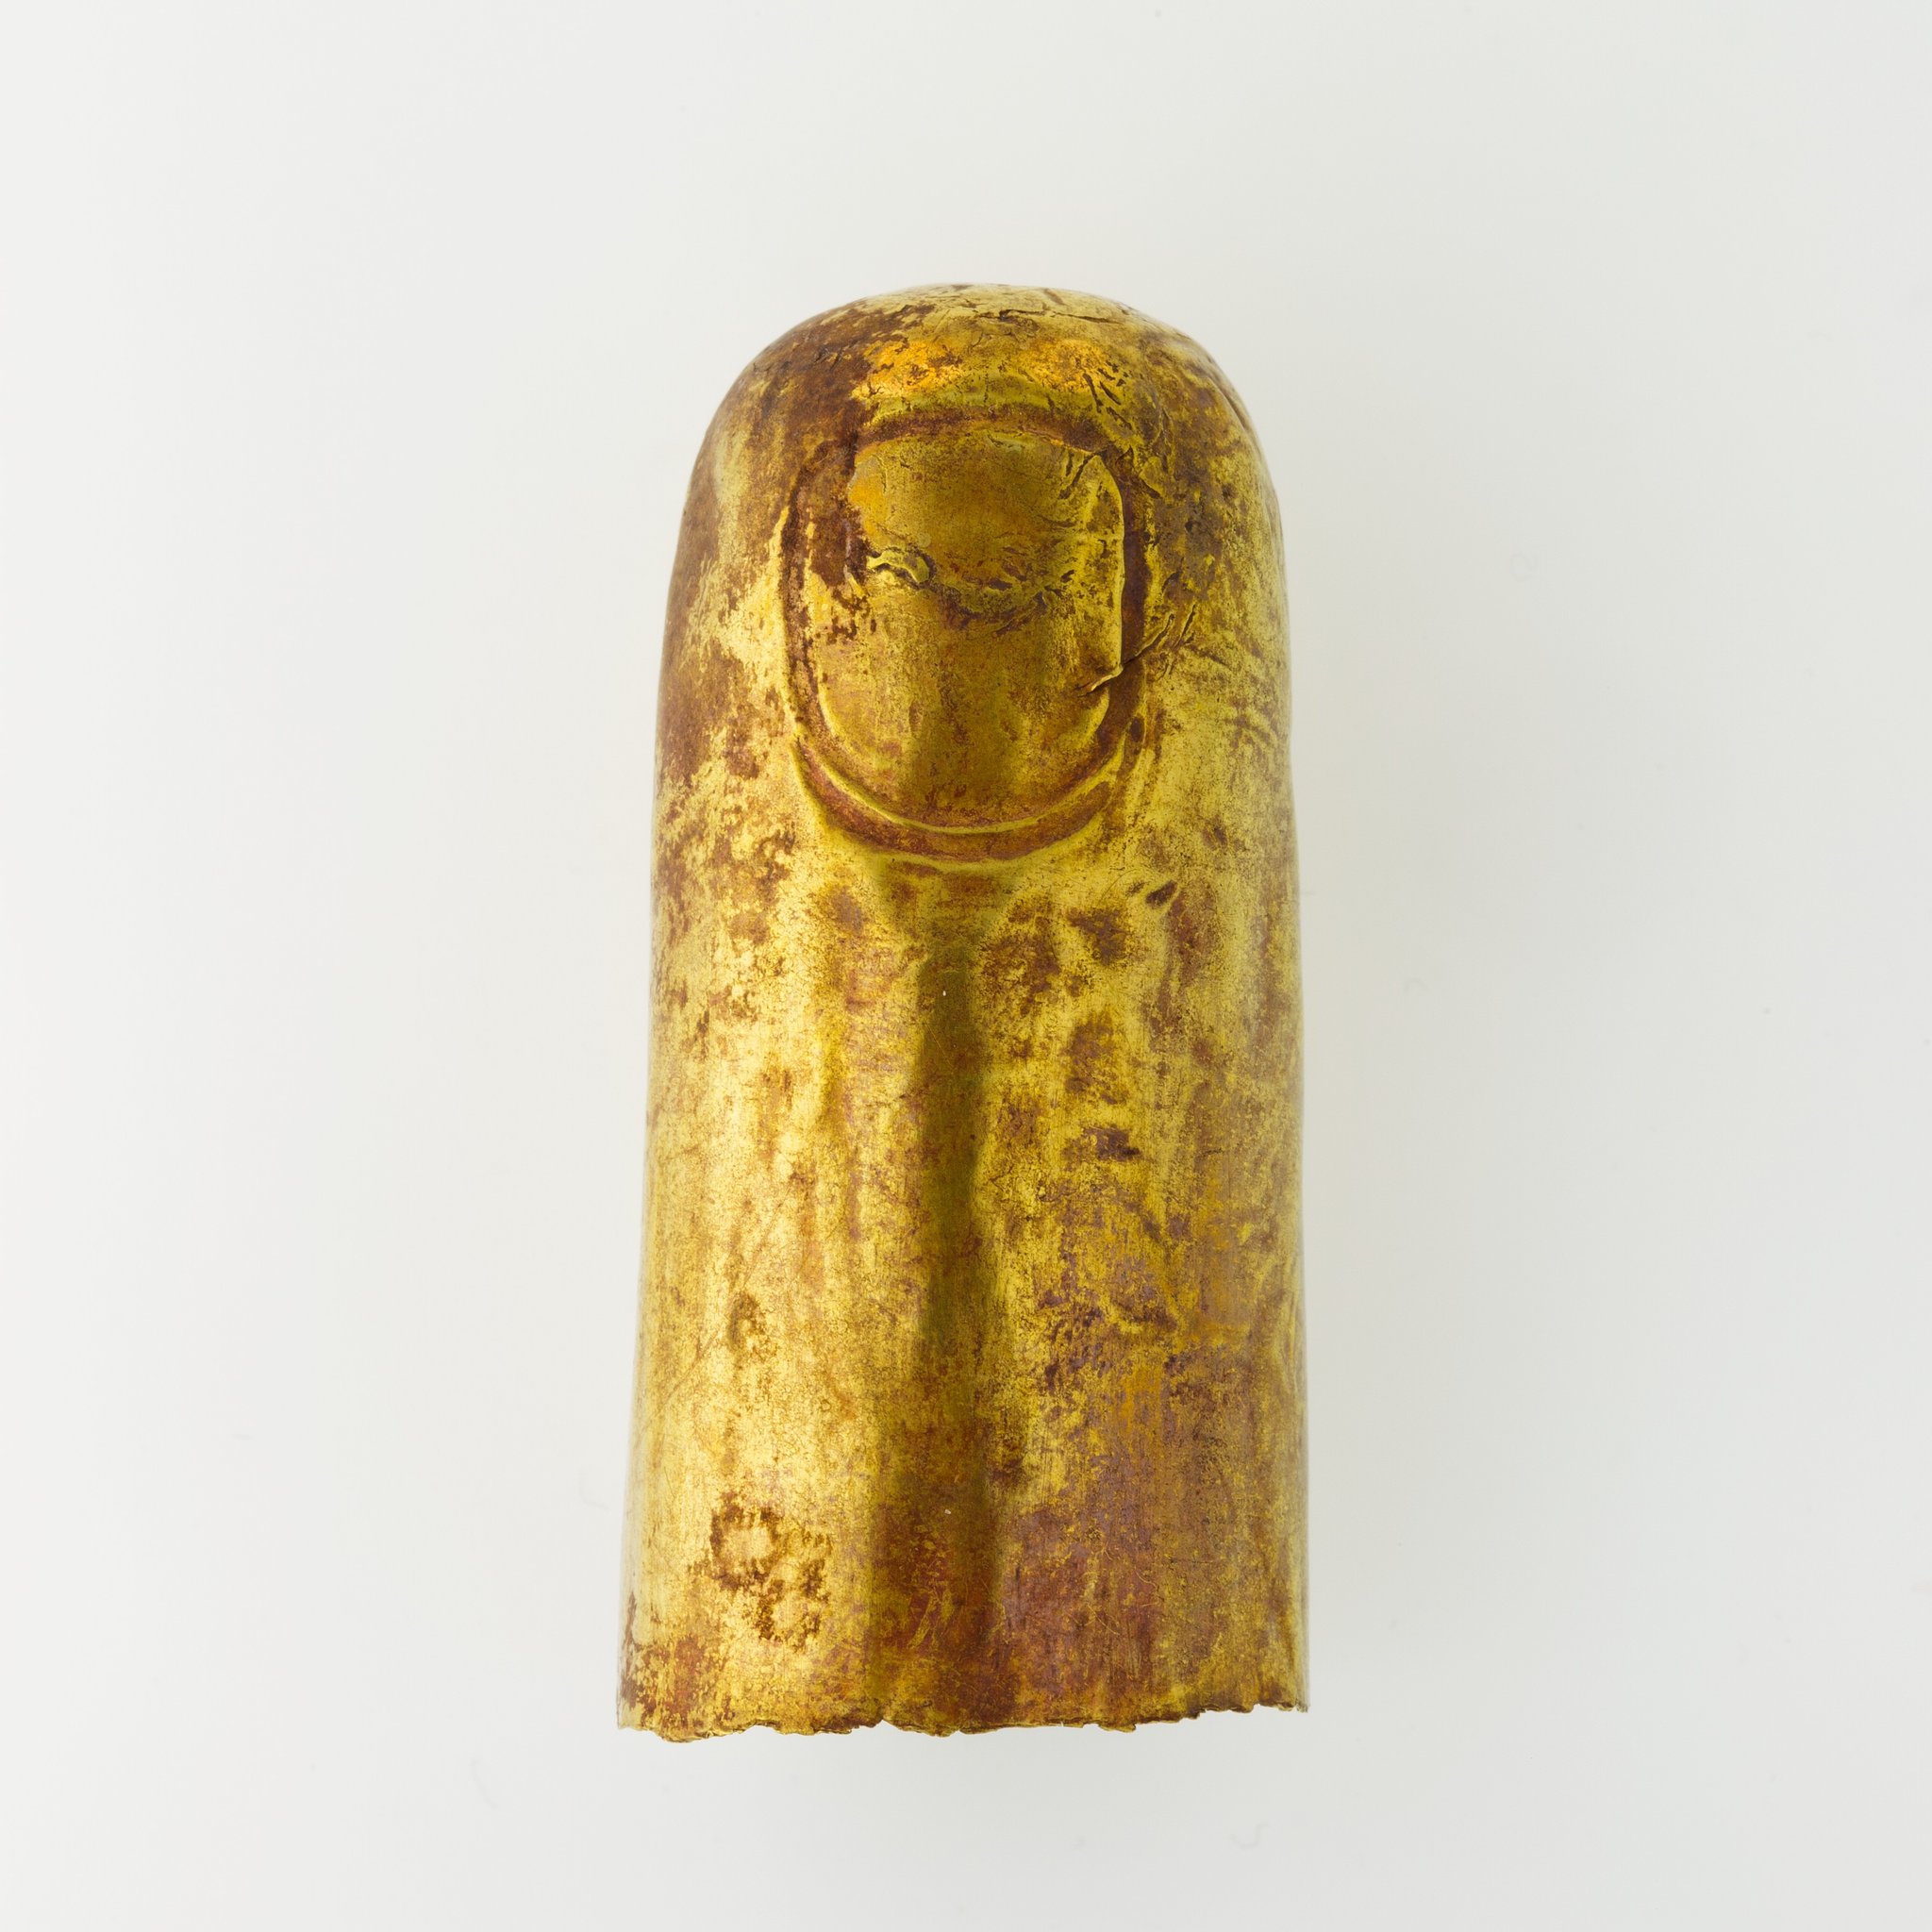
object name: finger stall, group 1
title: Finger Stall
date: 1479-1425 BCE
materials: gold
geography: egypt